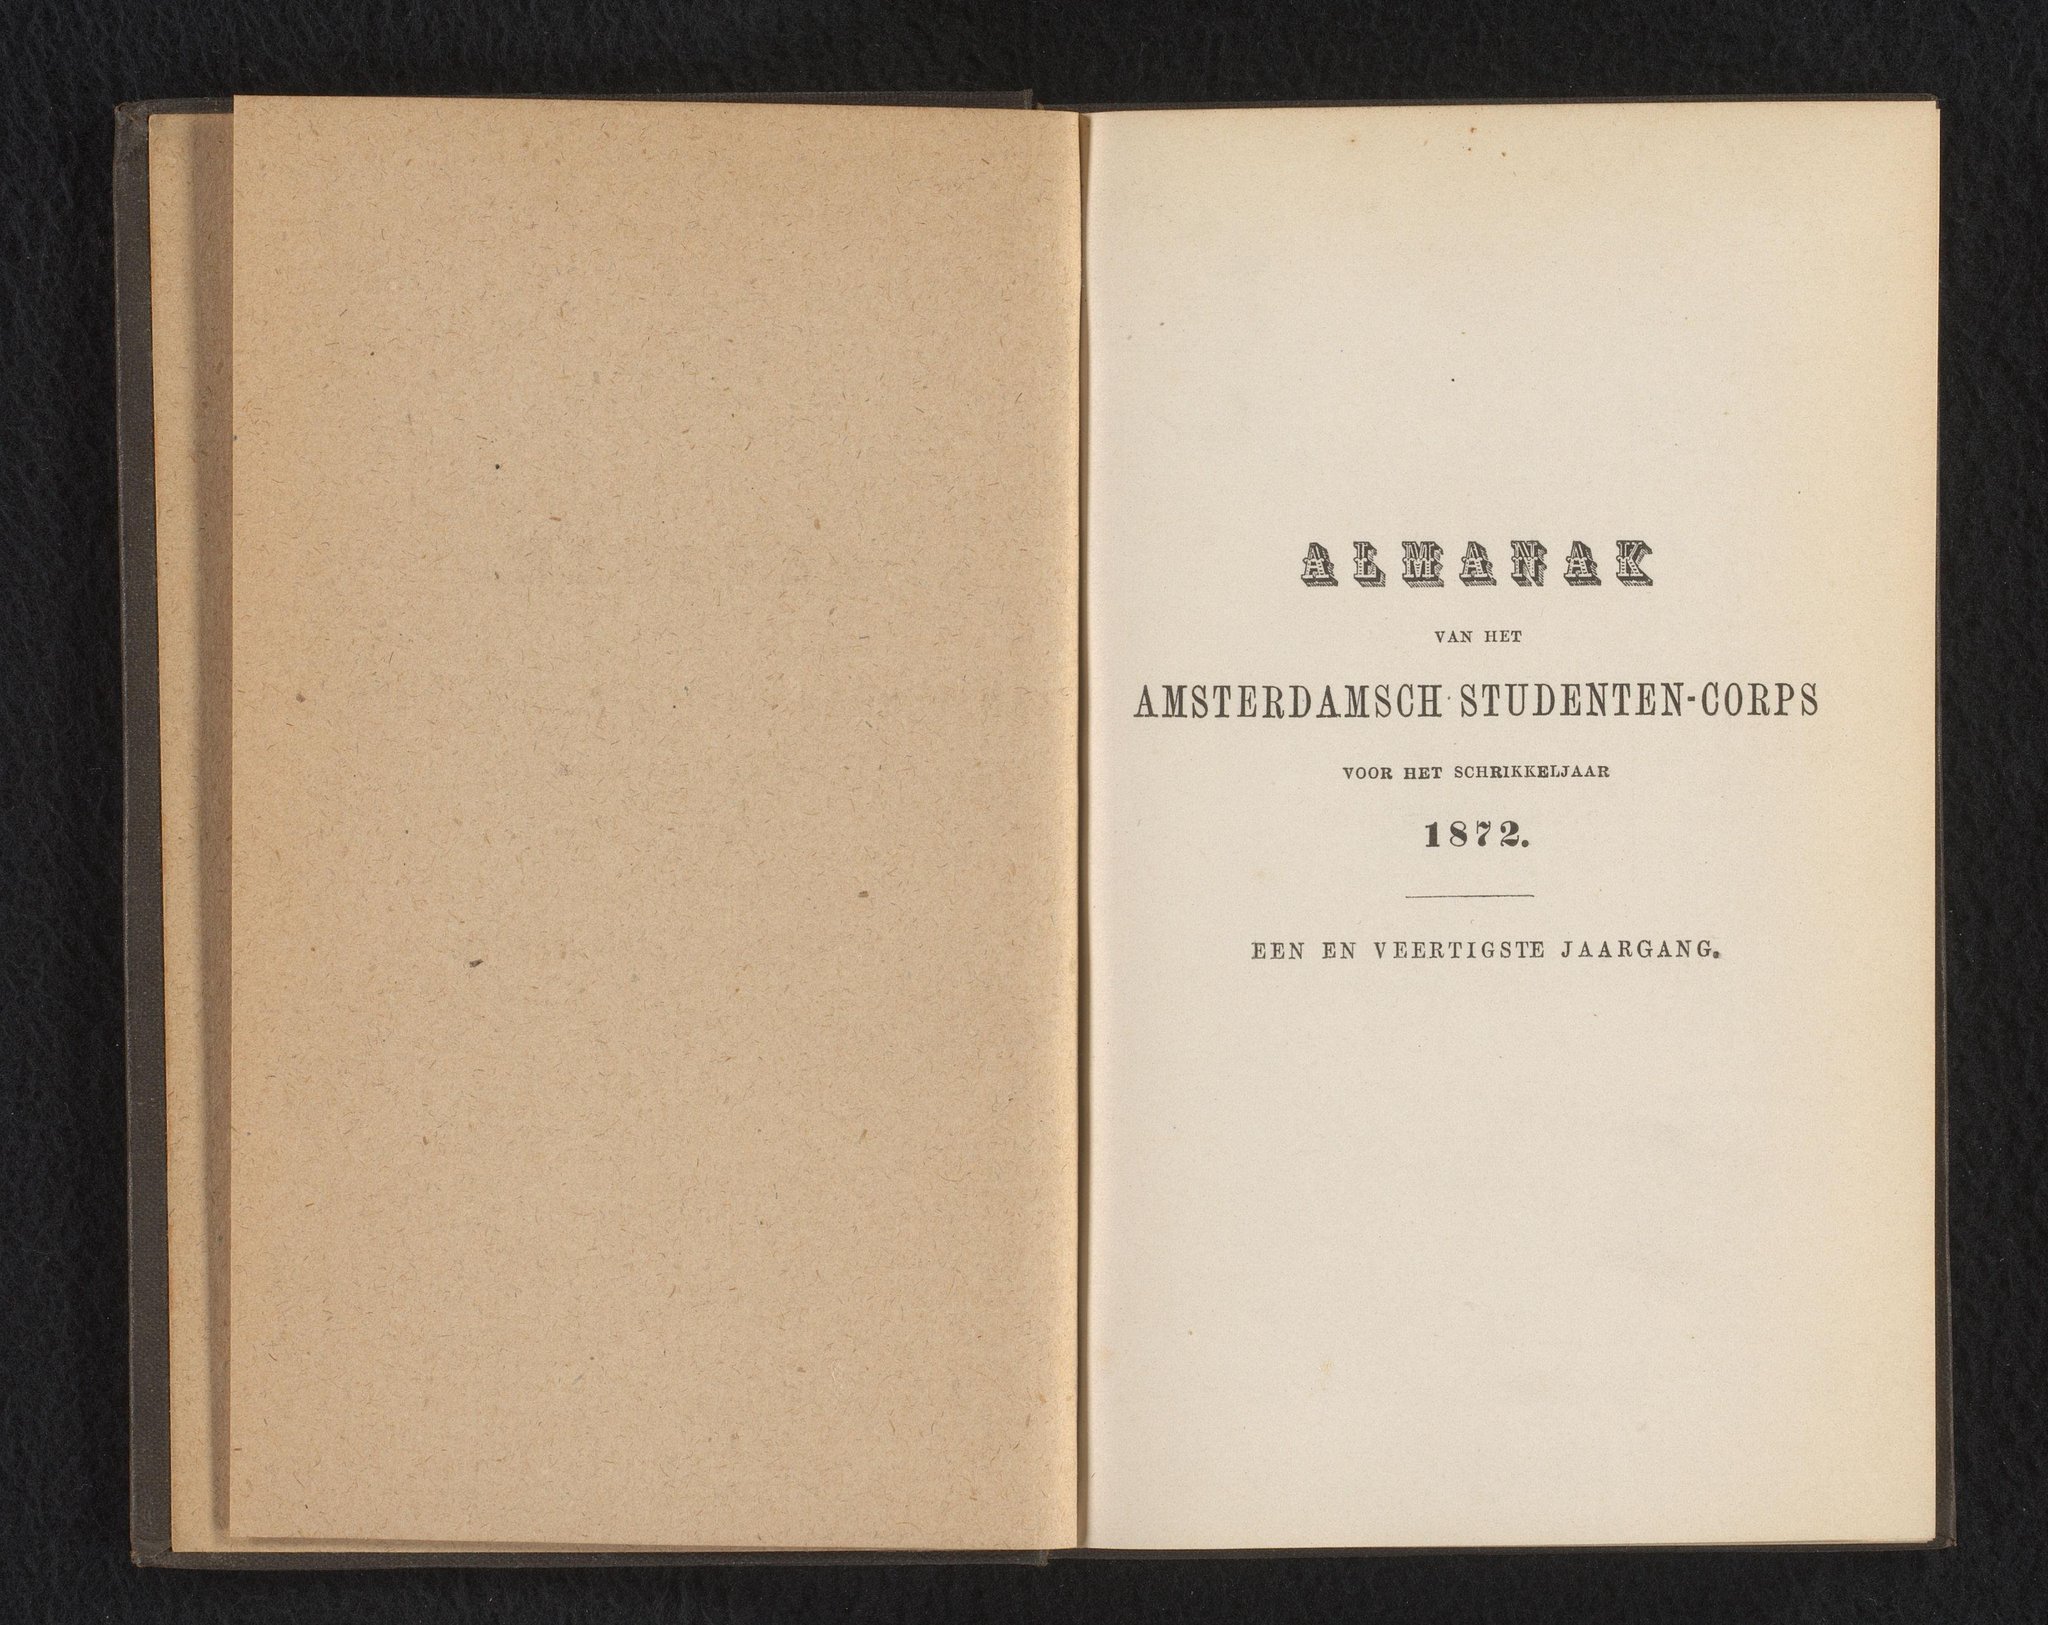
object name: book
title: Almanak van het Amsterdamsch studenten-corps voor het jaar 1872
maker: c.g. van der post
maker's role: printer, publisher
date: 1872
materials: paper, cardboard, linen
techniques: albumen print, engraving, letterpress printing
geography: amsterdam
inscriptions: name: ‘W. Dulass 1872.’